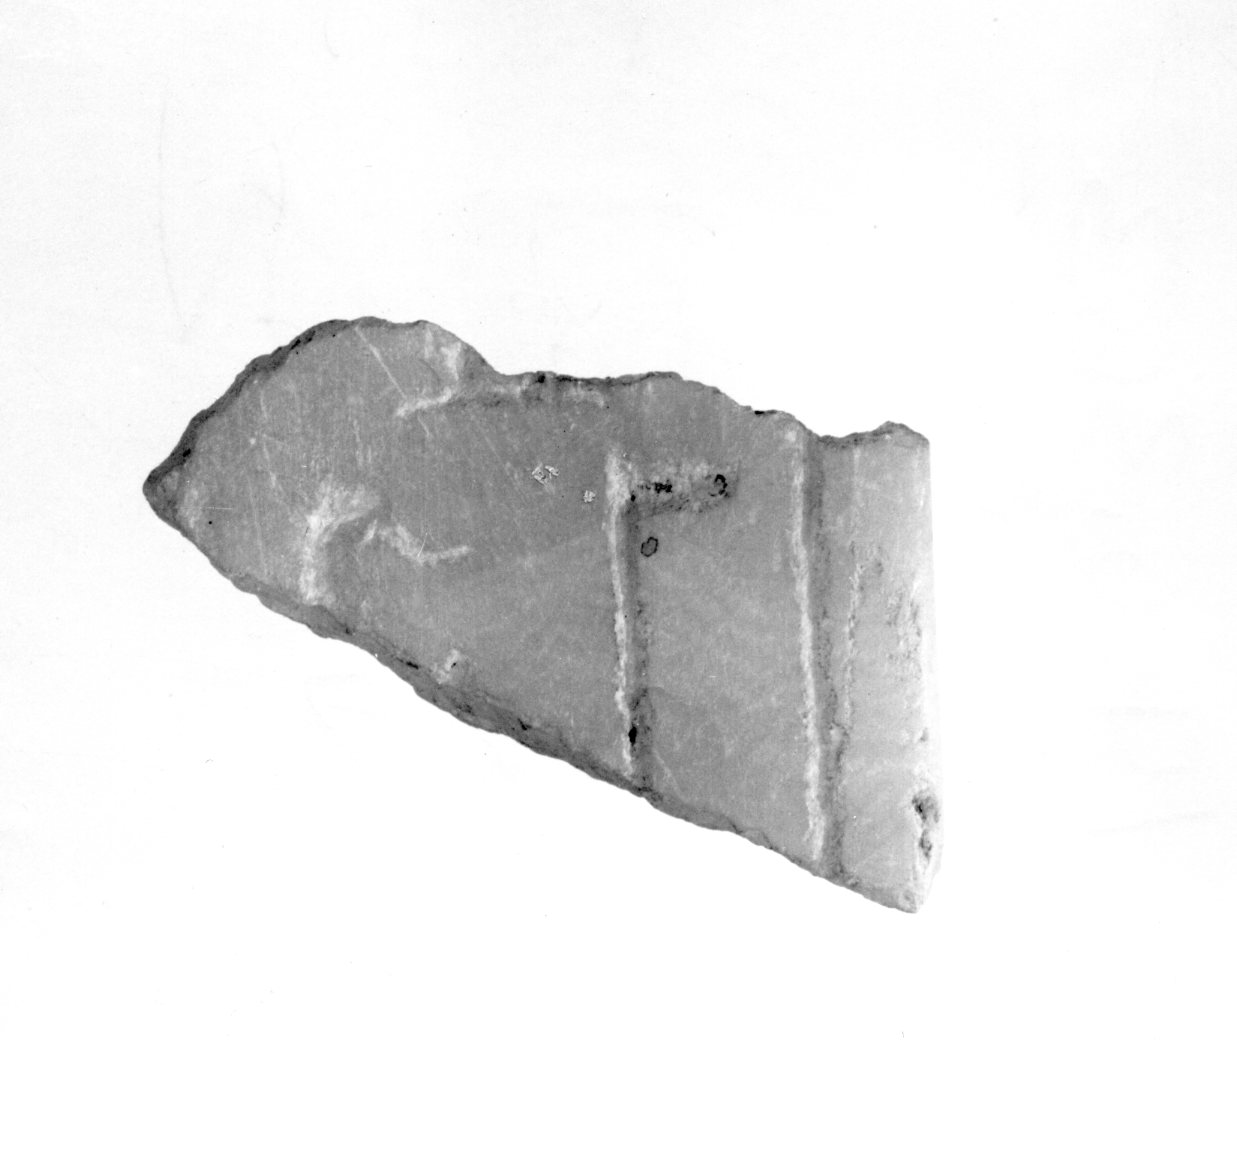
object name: canopic box, siptah, corner, text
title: Fragment of a Corner of Siptah's Canopic Chest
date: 1194-1188 BCE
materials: stone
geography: egypt